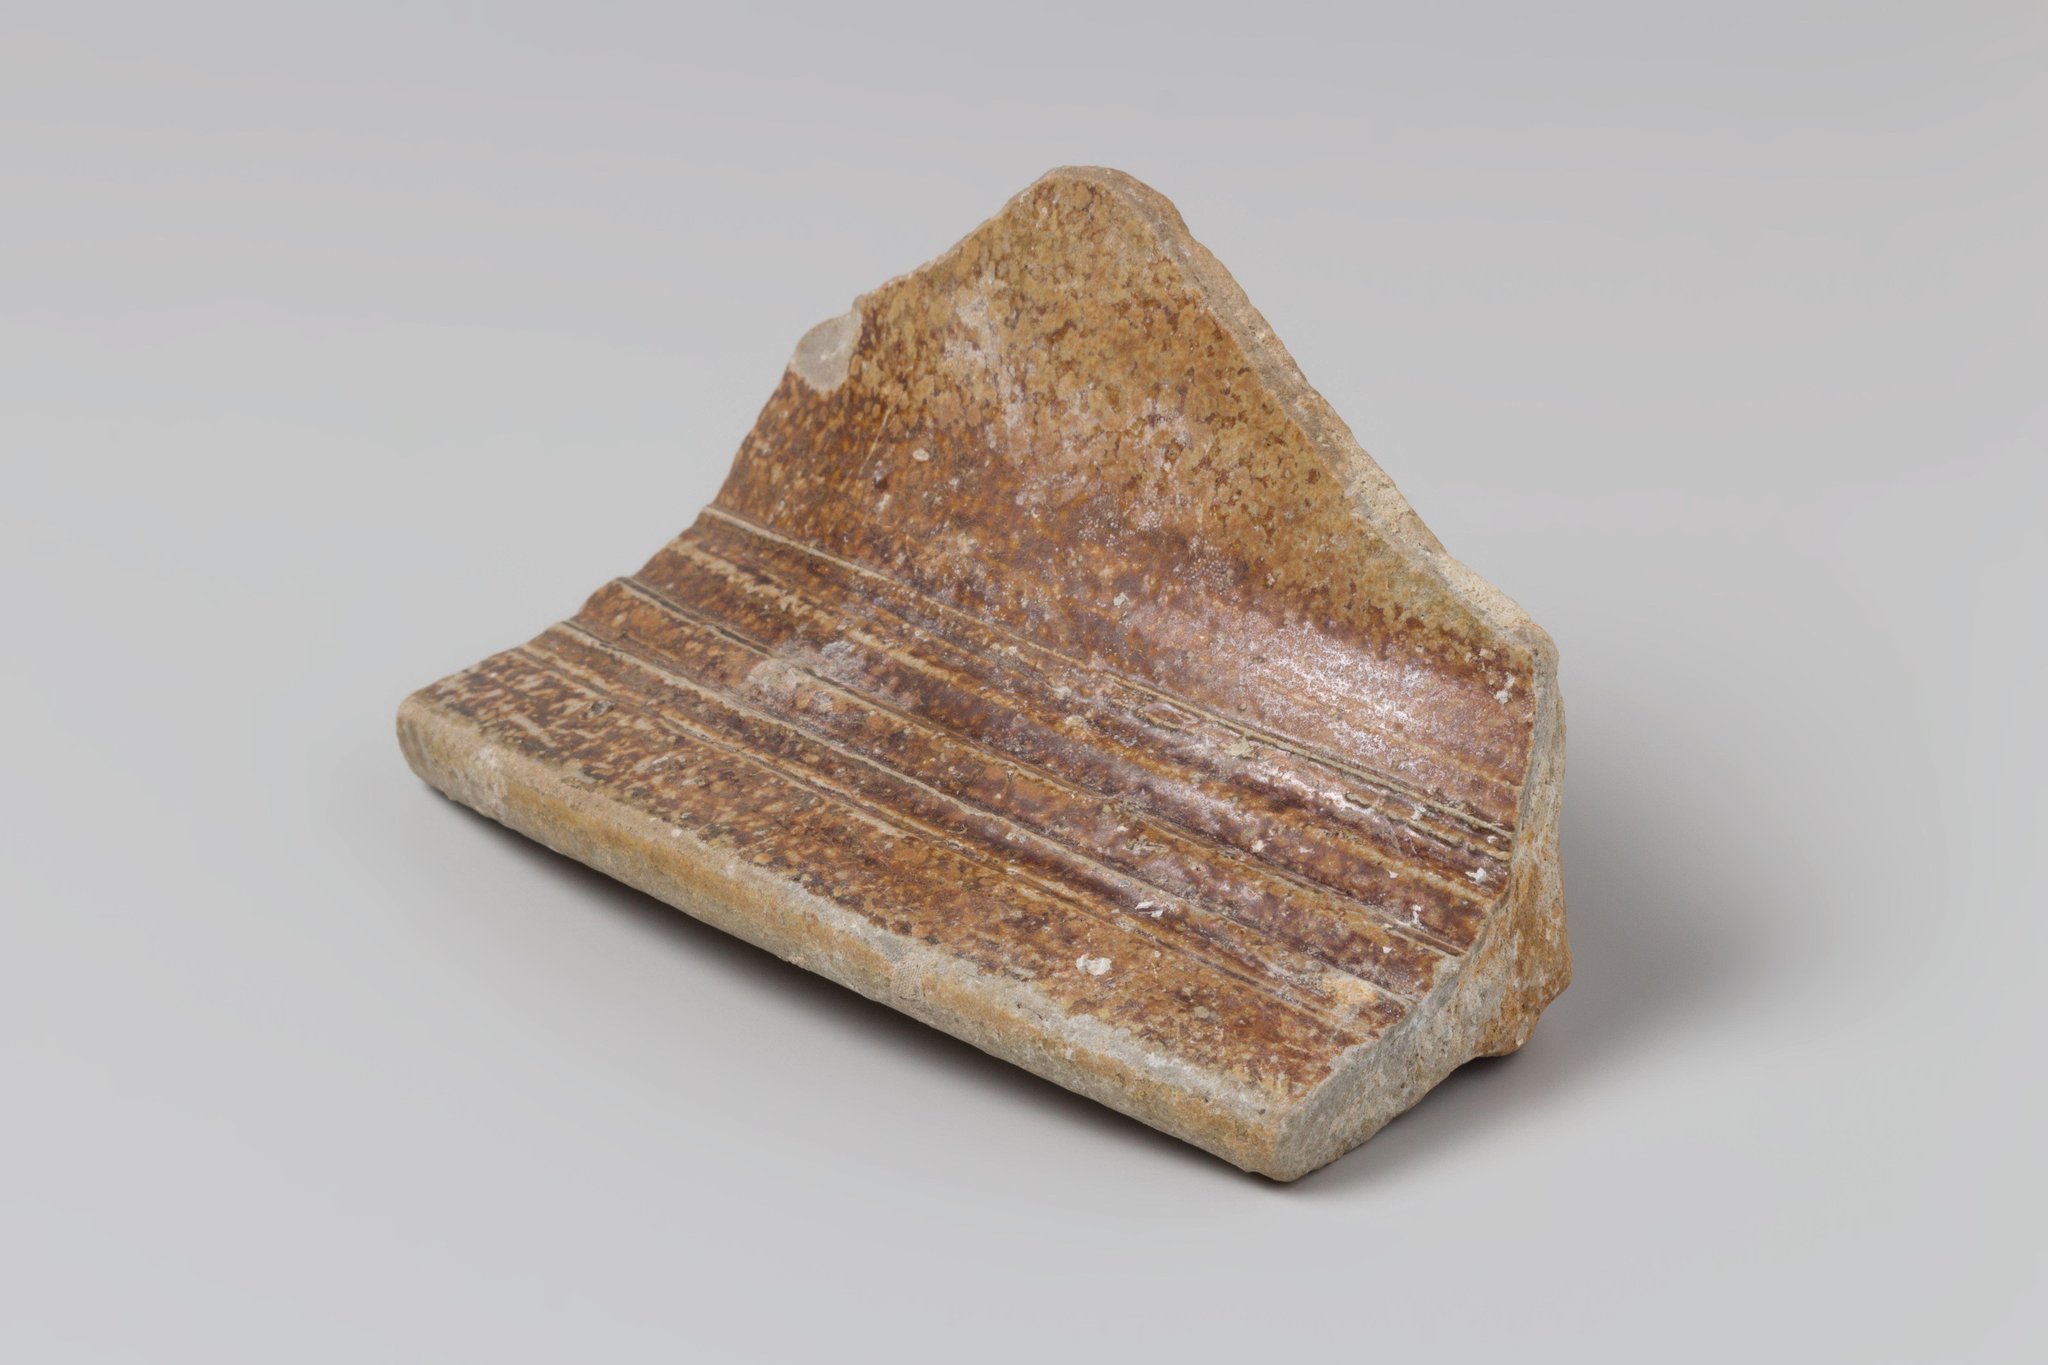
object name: sherd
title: Scherf van een voorraadpot uit het wrak van de Oost-Indiëvaarder Hollandia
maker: Anonymous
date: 1700-1743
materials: stoneware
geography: cologne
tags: verenigde oostindische compagnie, hollandia (schip), annet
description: Stoneware, Rhenish, Langerwehe-ware, storage-jar; fragm of rim, sim. NG 1980-27H909, everted, oblique, with relieved bands on the exterior.